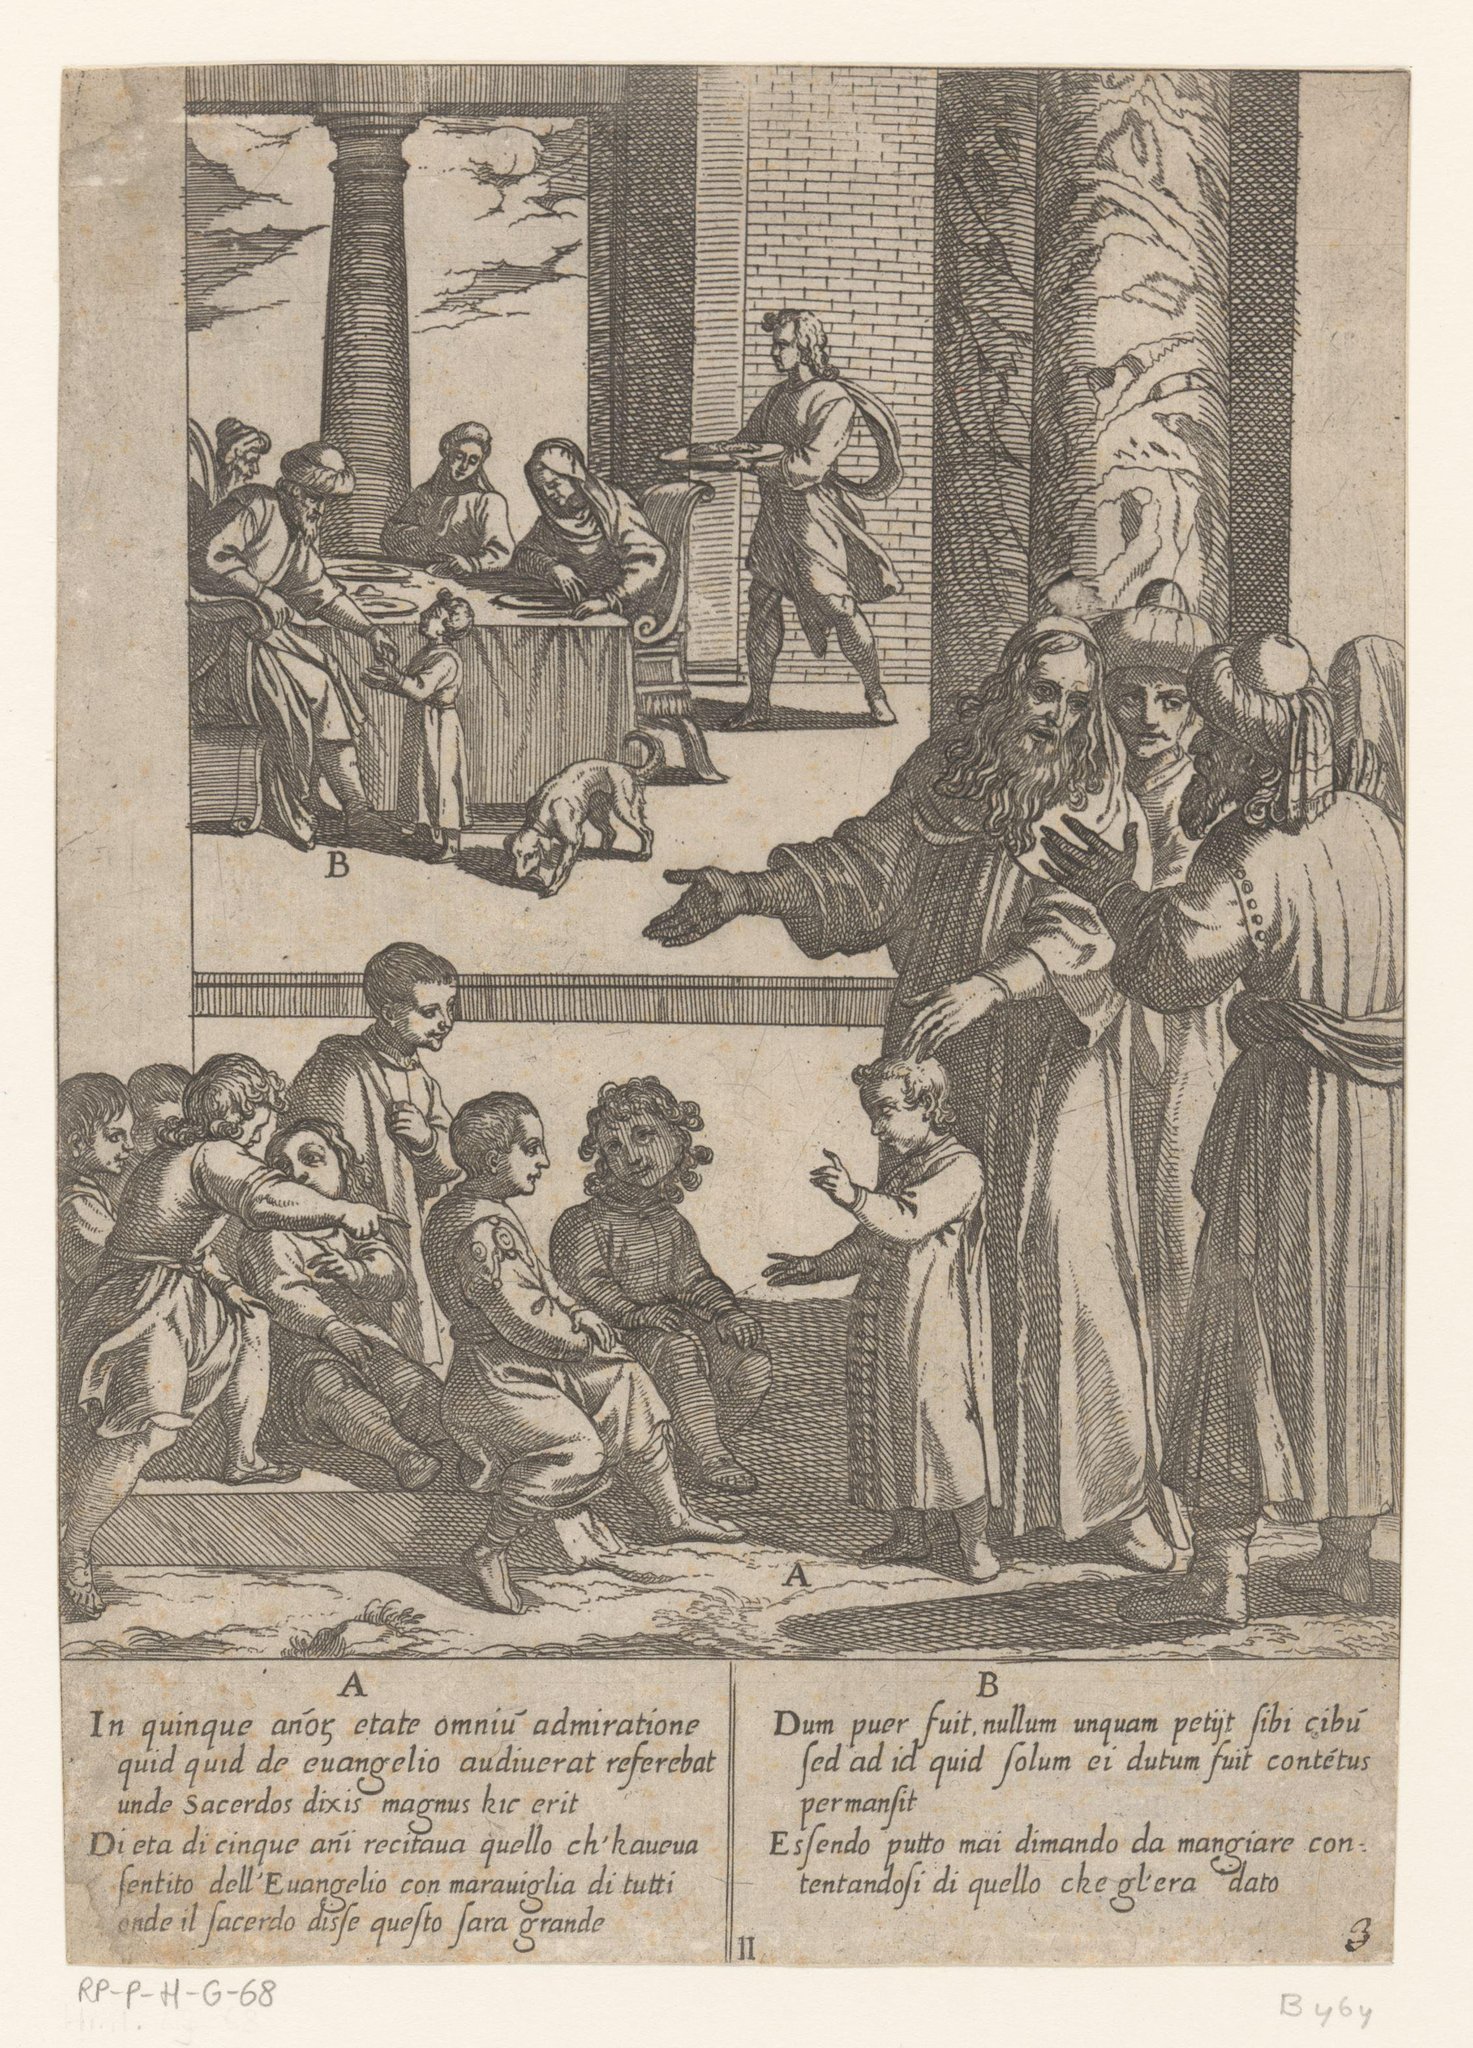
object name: print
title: Het leven van de heilige Antonius de Grote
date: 1598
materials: paper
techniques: etching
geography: rome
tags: the hermit antony abbot (antonius abbas) of egypt, also called the great; possible attributes: bell, book, t-shaped staff, flames, pig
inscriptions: collector's mark: Lugt 11, collector's mark: ‘Hinloopen’, number: ‘3’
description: Op de voorgrond de jonge Antonius die met een groep kinderen zijn kennis van de Evangeliën deelt. Op de achtergrond Antonius bij een groep volwassenen aan een tafel. Italiaanse en Latijnse tekst in twee kolommen in de ondermarge.